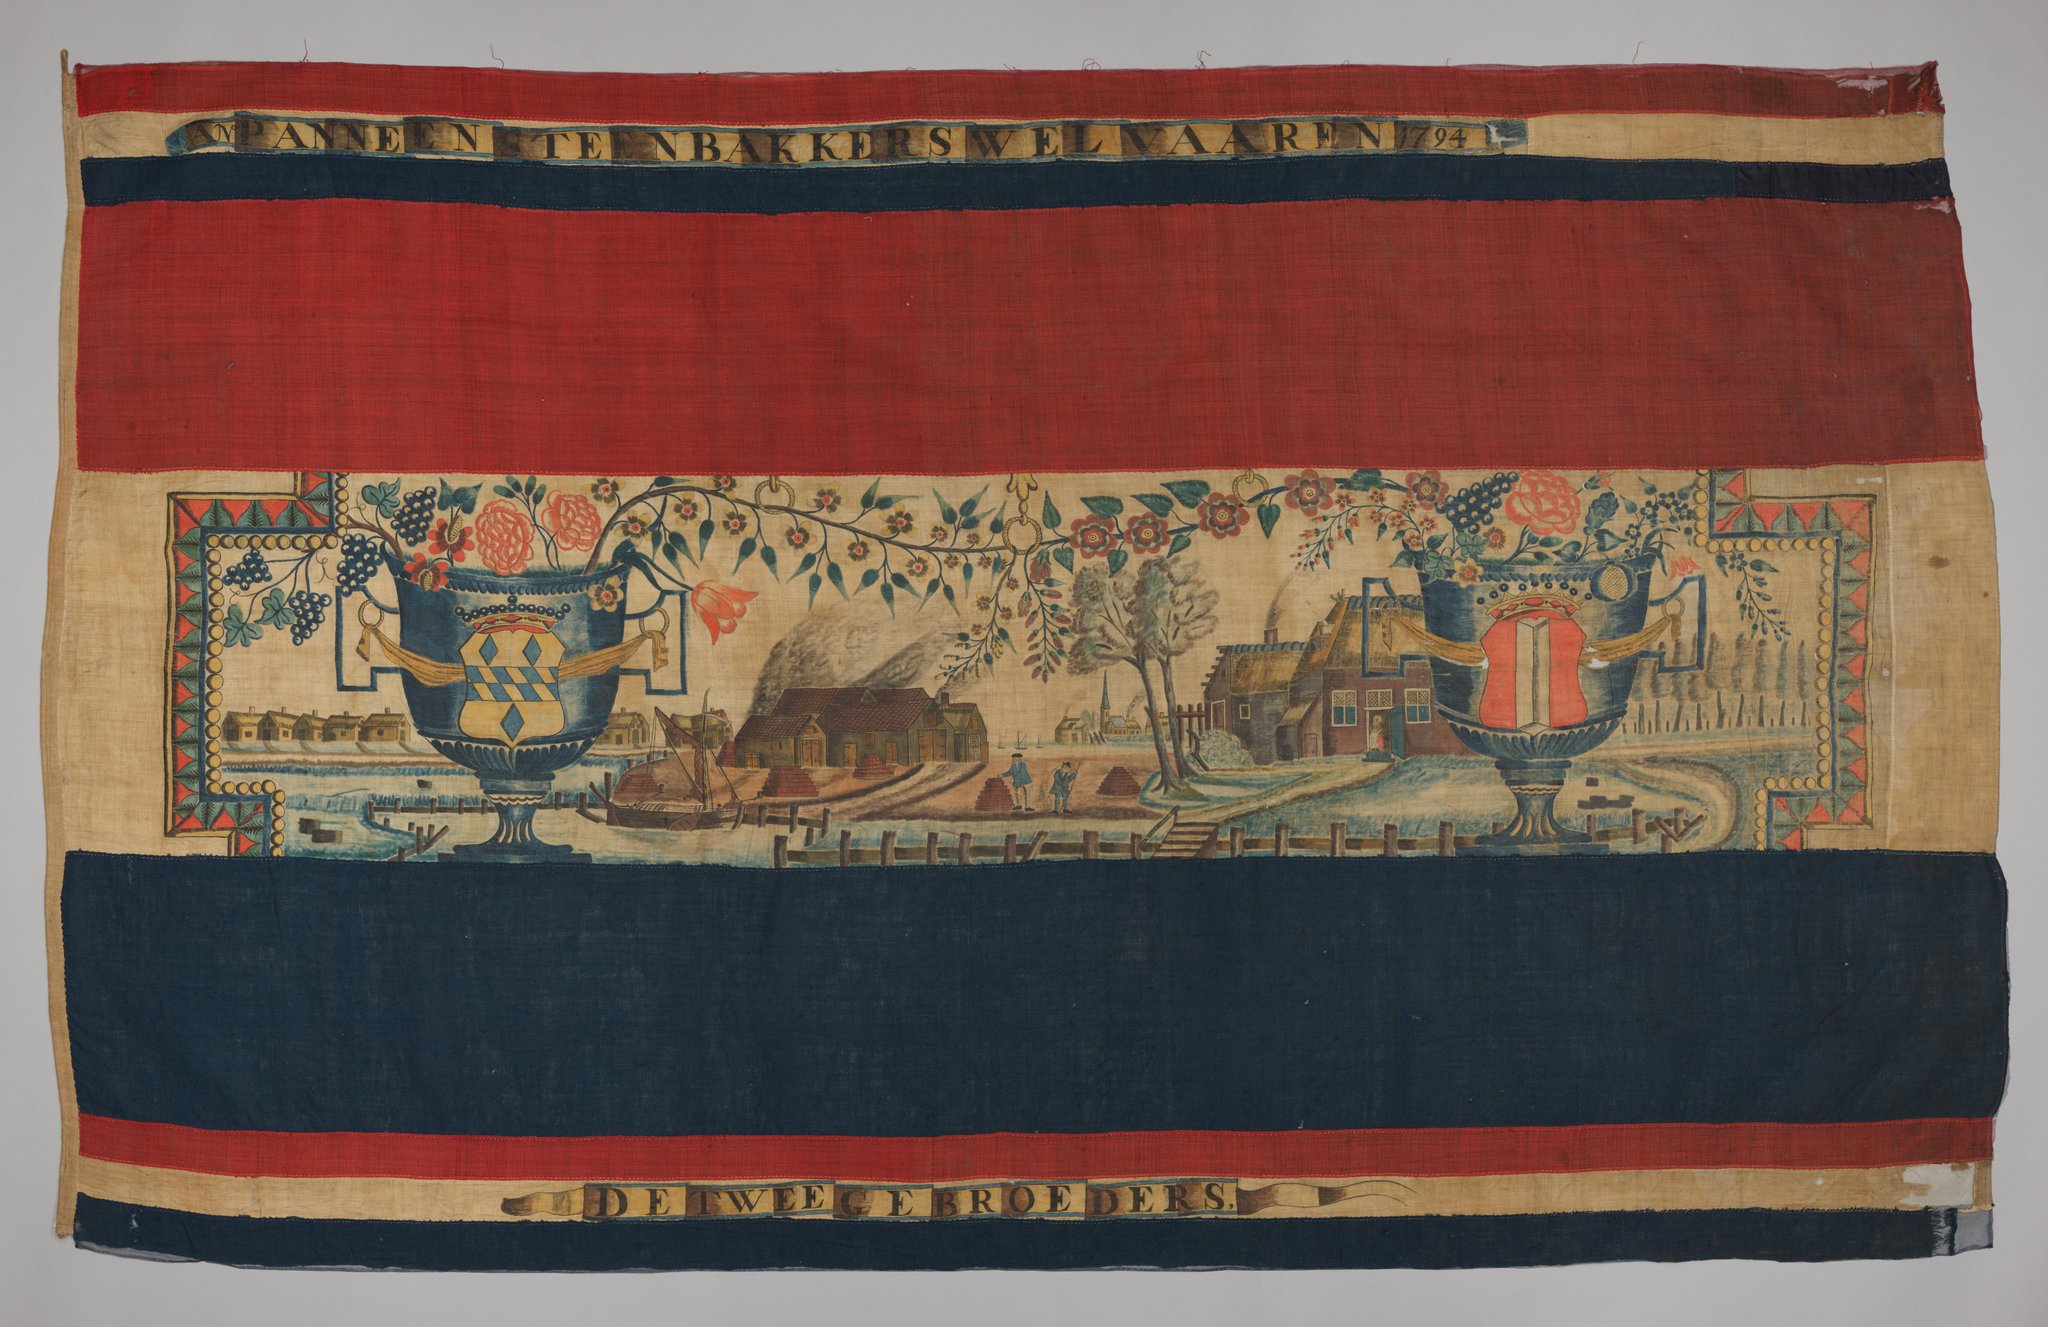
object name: flag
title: Nederlandse vlag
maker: Anonymous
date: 1794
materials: paint, wool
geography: netherlands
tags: dordrecht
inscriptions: inscription: ‘DE TWEE GEBROEDERS’, inscription: ‘AN/PANNE EN STEENBAKKERS WELVAAREN/1794’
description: Vlag met banen rood-wit-blauw. Op wit een voorstelling van land temidden van water. Op het land diverse gebouwen waarvoor stapels stenen. Links ligt een schip aan de kade. Op de achtergrond een kerk. Links en rechts van de voorstelling een blauwe amfoor met o.a. bloemen, druivetakken die in het midden naar beneden hangen. Beide amforen zijn voorzien van een wapen waarachter langs een sjerp is gedrapeerd. Het linkerwapen is dat van Woerden; het rechter dat van Dordrecht. Links en rechts wordt de voorstelling afgesloten met een rechthoekige uitspringende lijst. Aan de boven- en onderzijden zijn banen rood-wit-blauw toegevoegd. In de witte banen: AN/PANNE EN STEENBAKKERS WELVAAREN/1794, en DE TWEE GEBROEDERS.